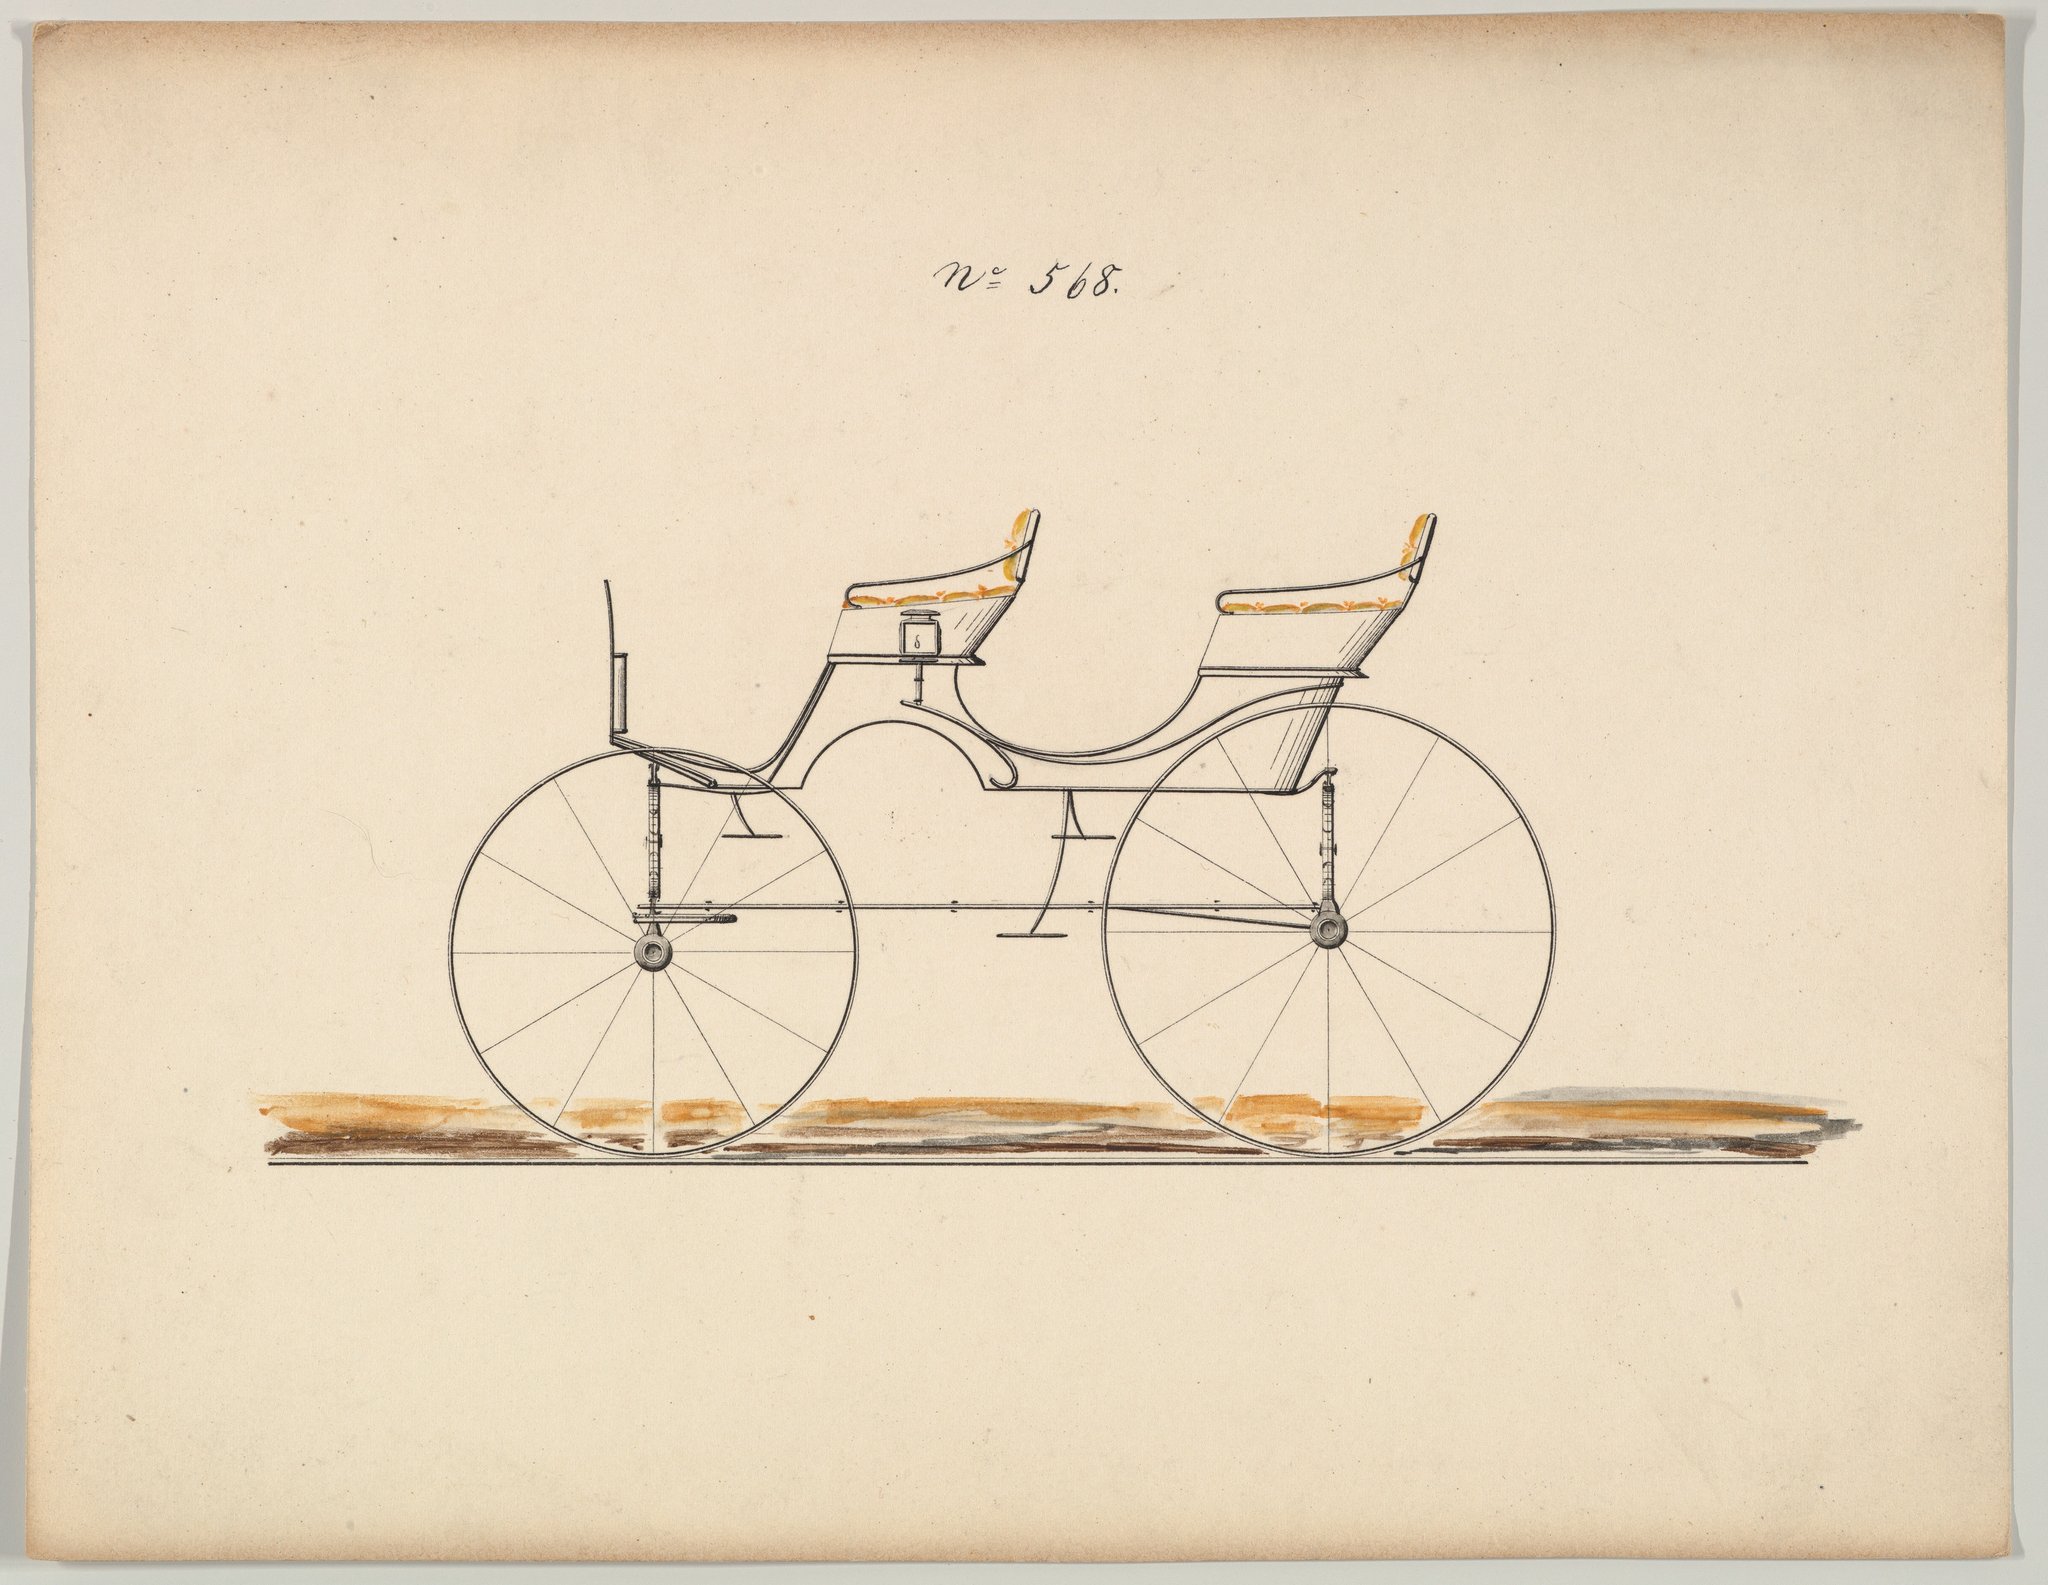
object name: drawing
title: Two Seat Phaeton #568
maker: brewster & co.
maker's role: manufacturer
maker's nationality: american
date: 1865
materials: ink, watercolor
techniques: pen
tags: carriages